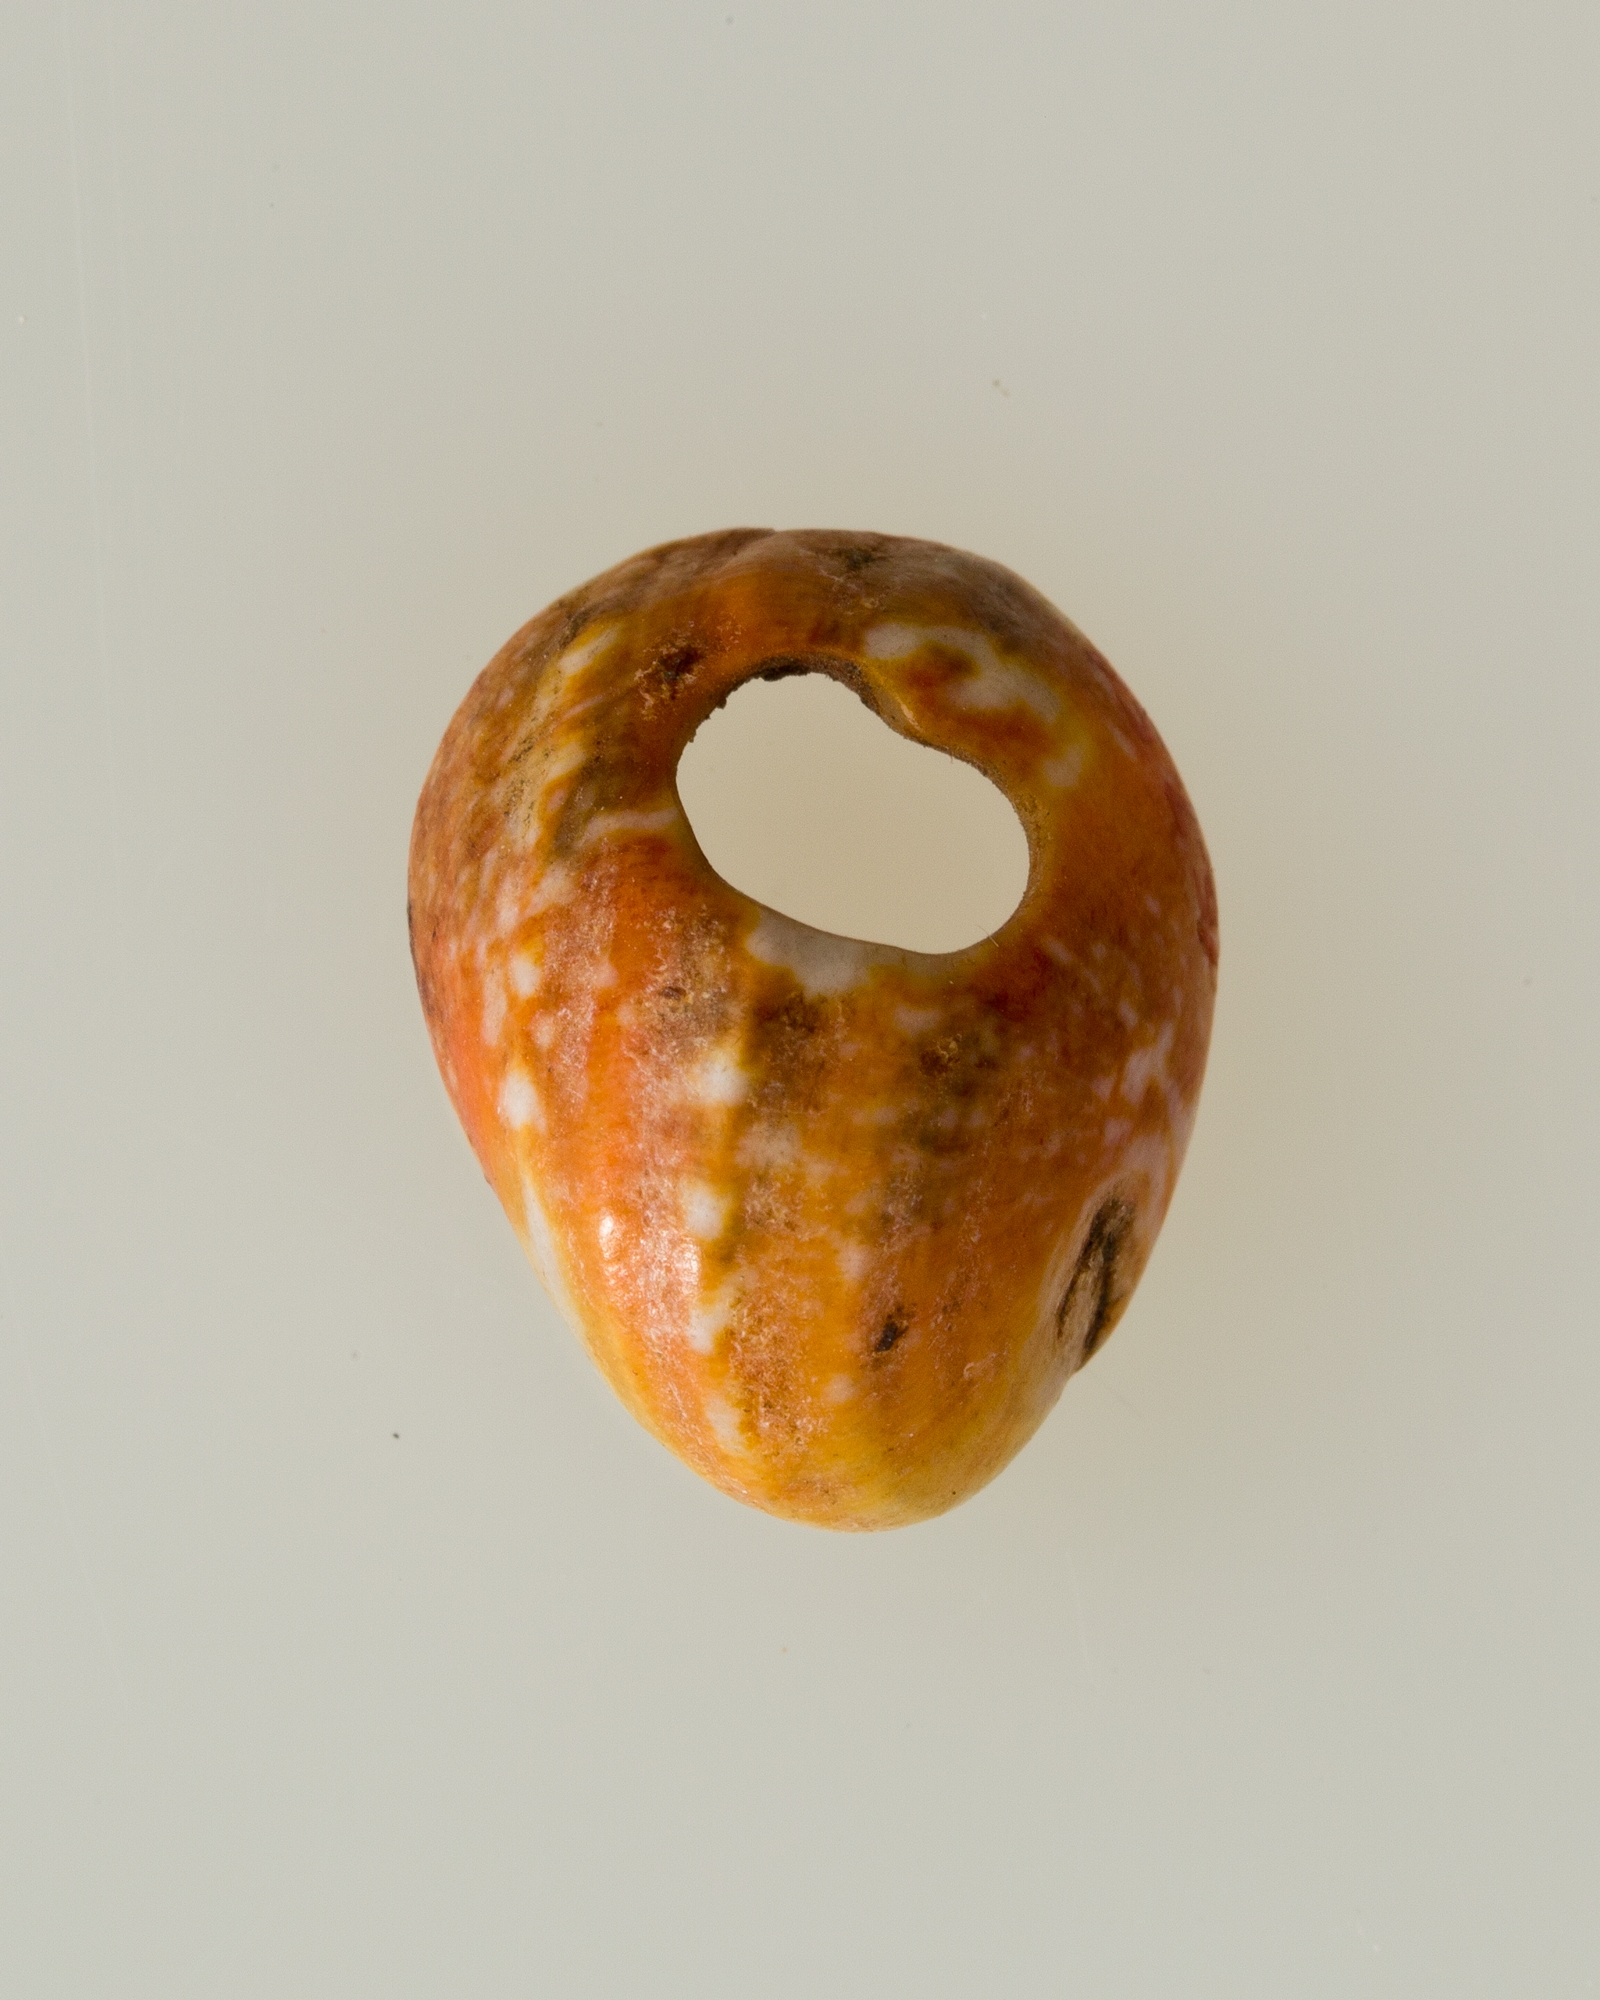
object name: pendant, shell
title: Shell pendant or bead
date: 3850-2960 BCE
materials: shell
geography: egypt